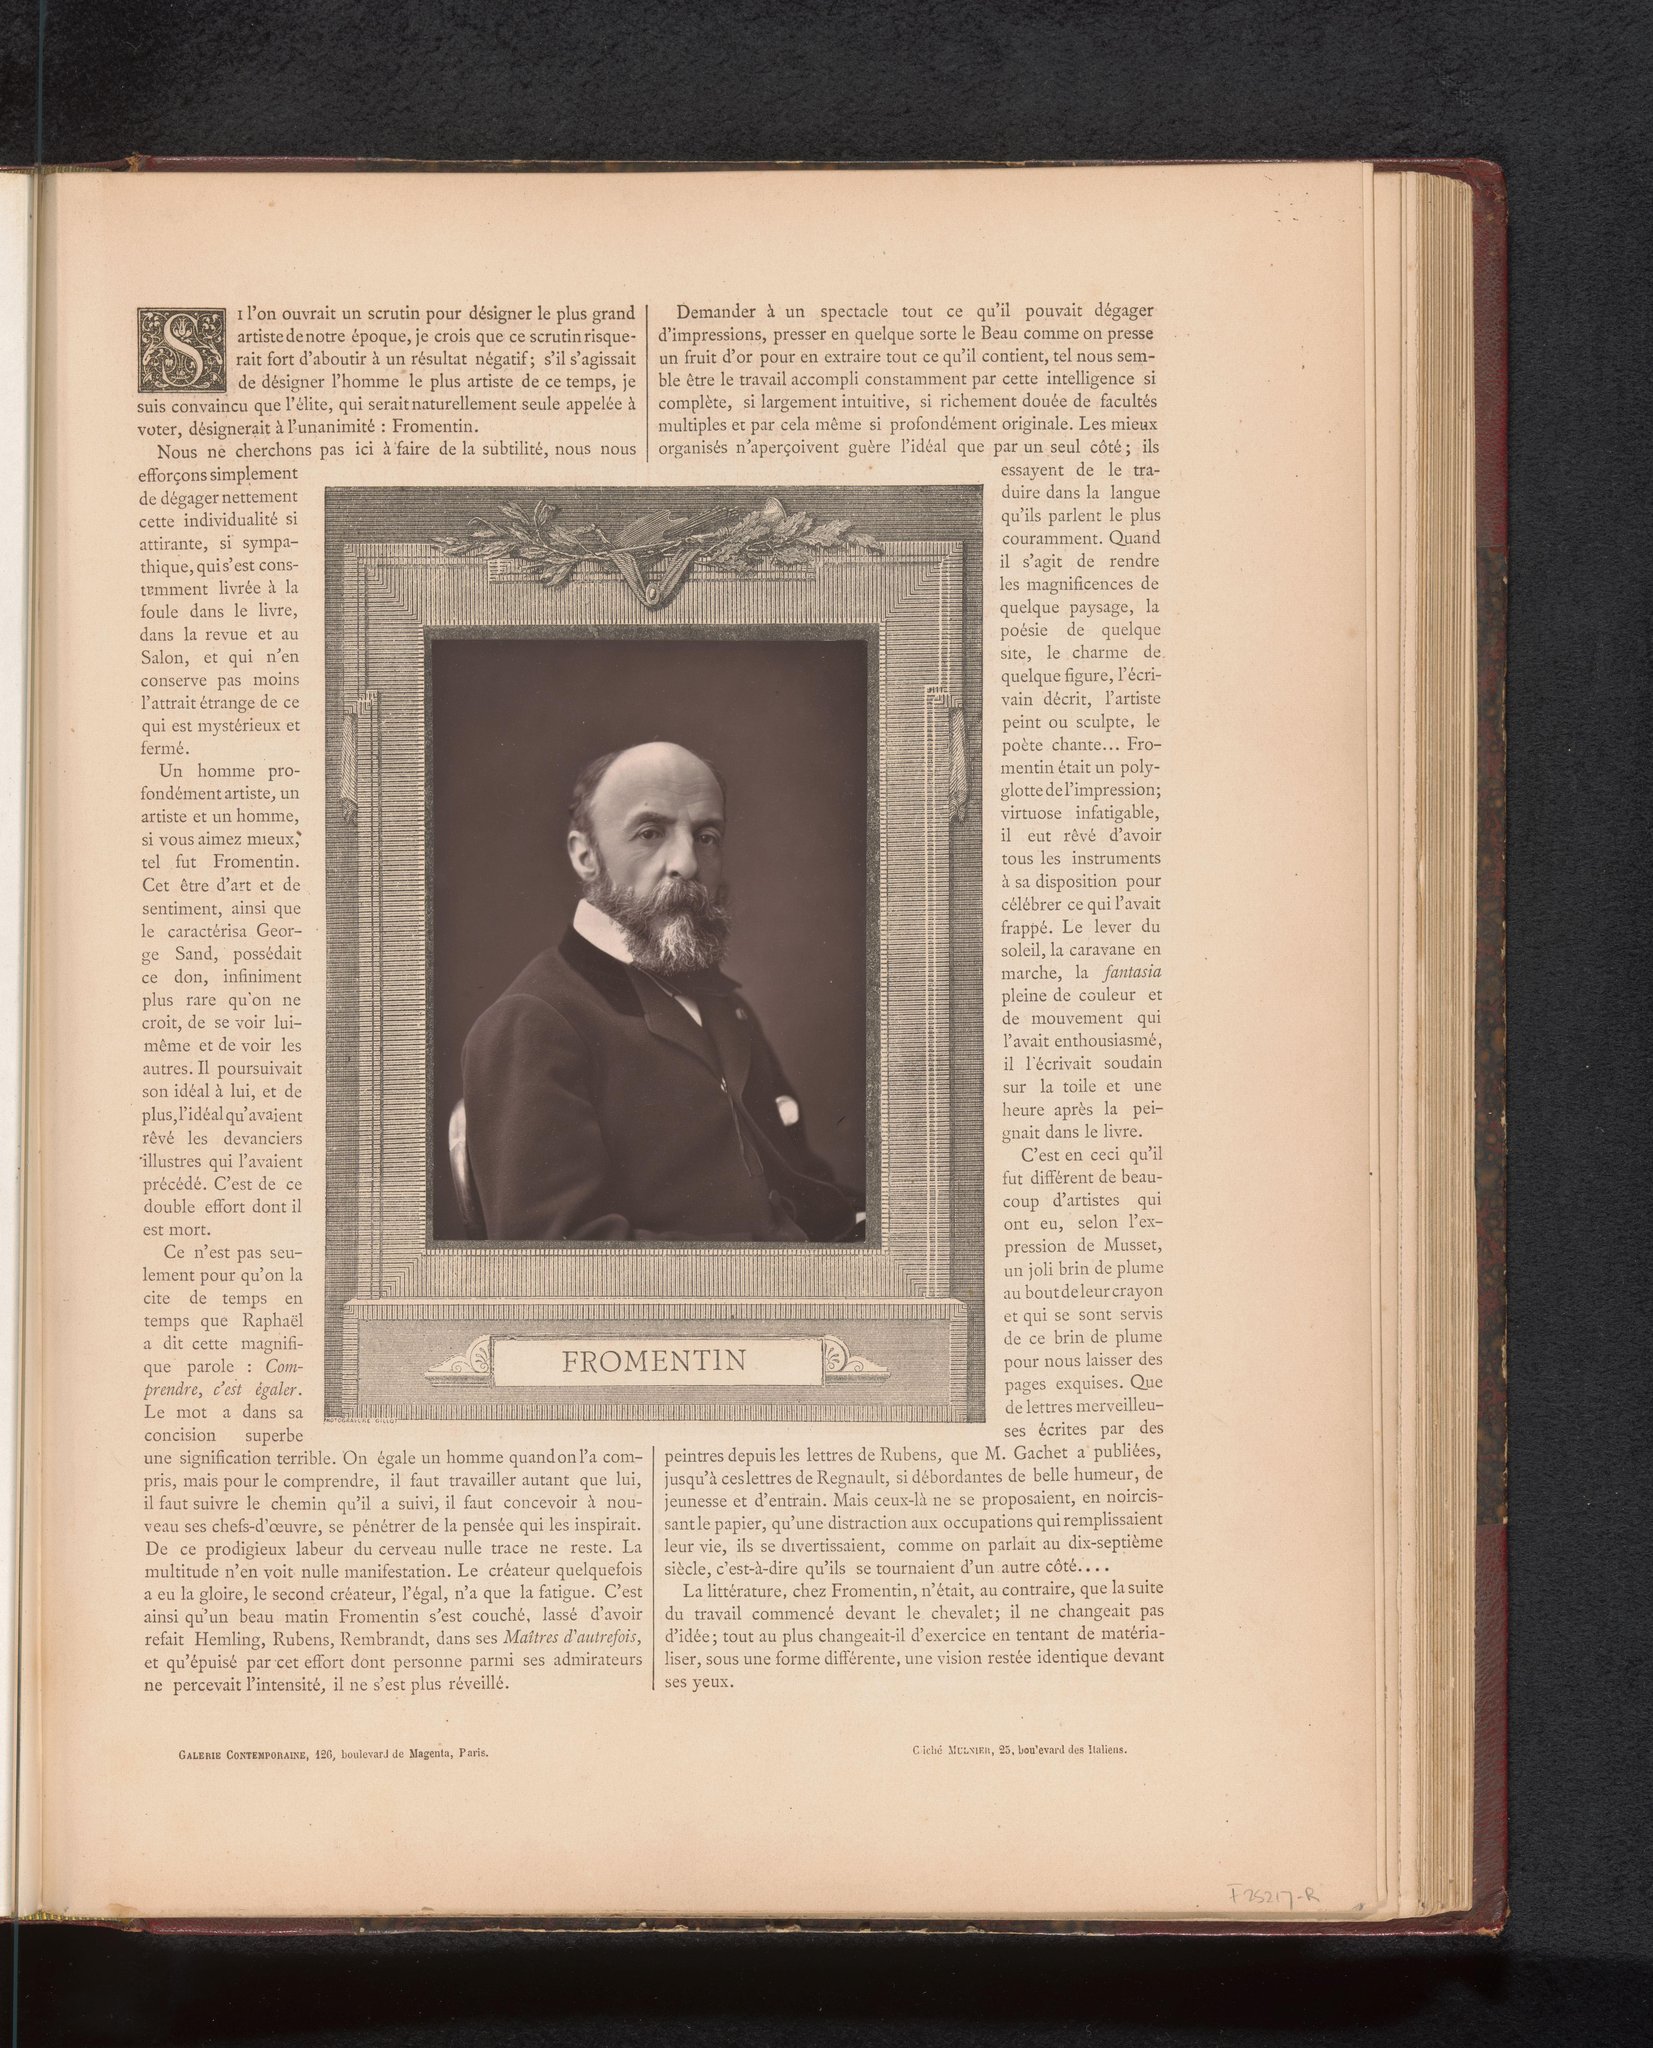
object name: photomechanical print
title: Portret van Eugène Fromentin-Dupeux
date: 1872-1877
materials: paper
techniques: printing block, woodburytype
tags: eugène fromentin-dupeux, adult man, historical persons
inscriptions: inscription: ‘Galerie Contemporaine, 126, boulevard de Magenta.’